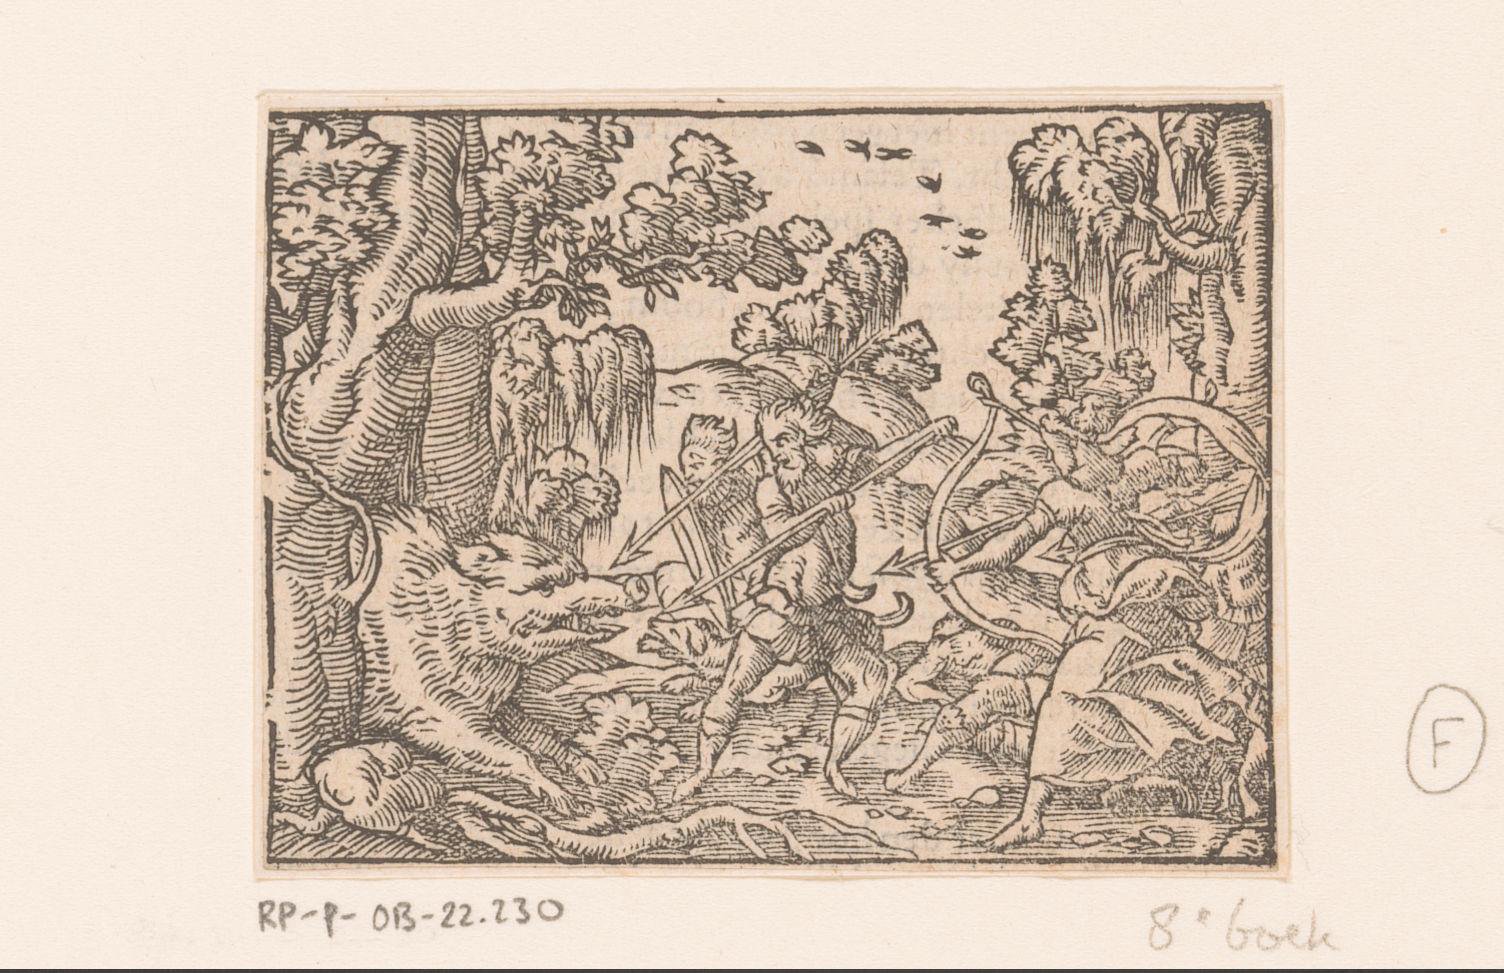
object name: book illustration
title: Atalanta en Meleager doden het zwijn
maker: Anonymous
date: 1524-1612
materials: paper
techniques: woodcut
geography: nuremberg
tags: atalanta and meleager hunting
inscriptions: collector's mark: Lugt 240